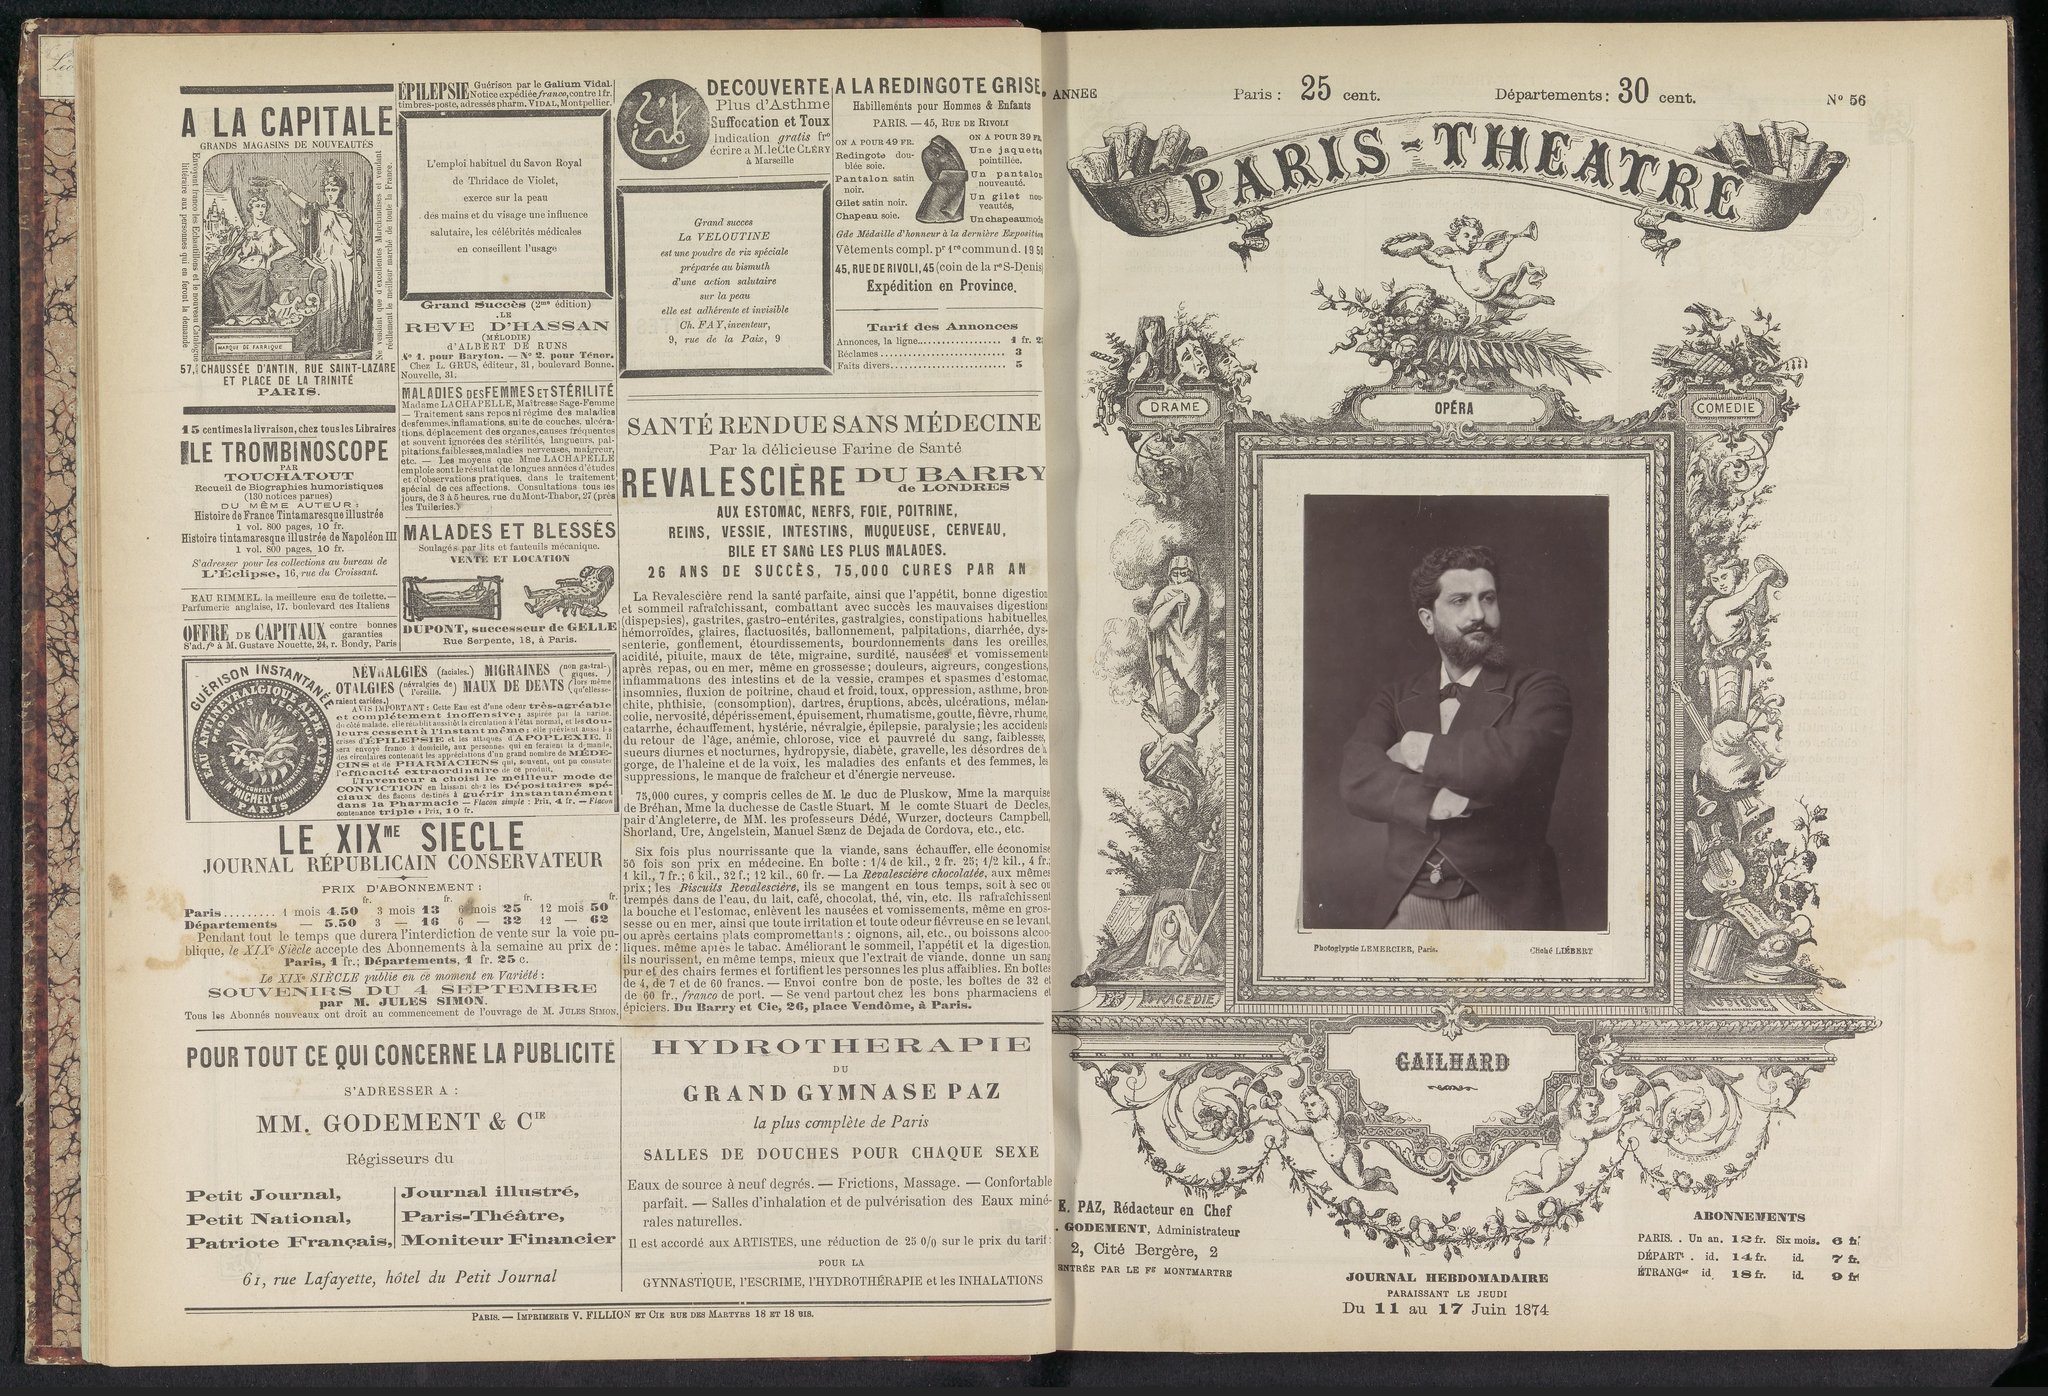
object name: photomechanical print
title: Portret van Pedro Gailhard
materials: paper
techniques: woodburytype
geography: france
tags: portrait of opera-singer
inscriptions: number: ‘No 56’, inscription: ‘Journal hebdomadaire paraissant le jeudi Du 11 au 17 Juin 1874’